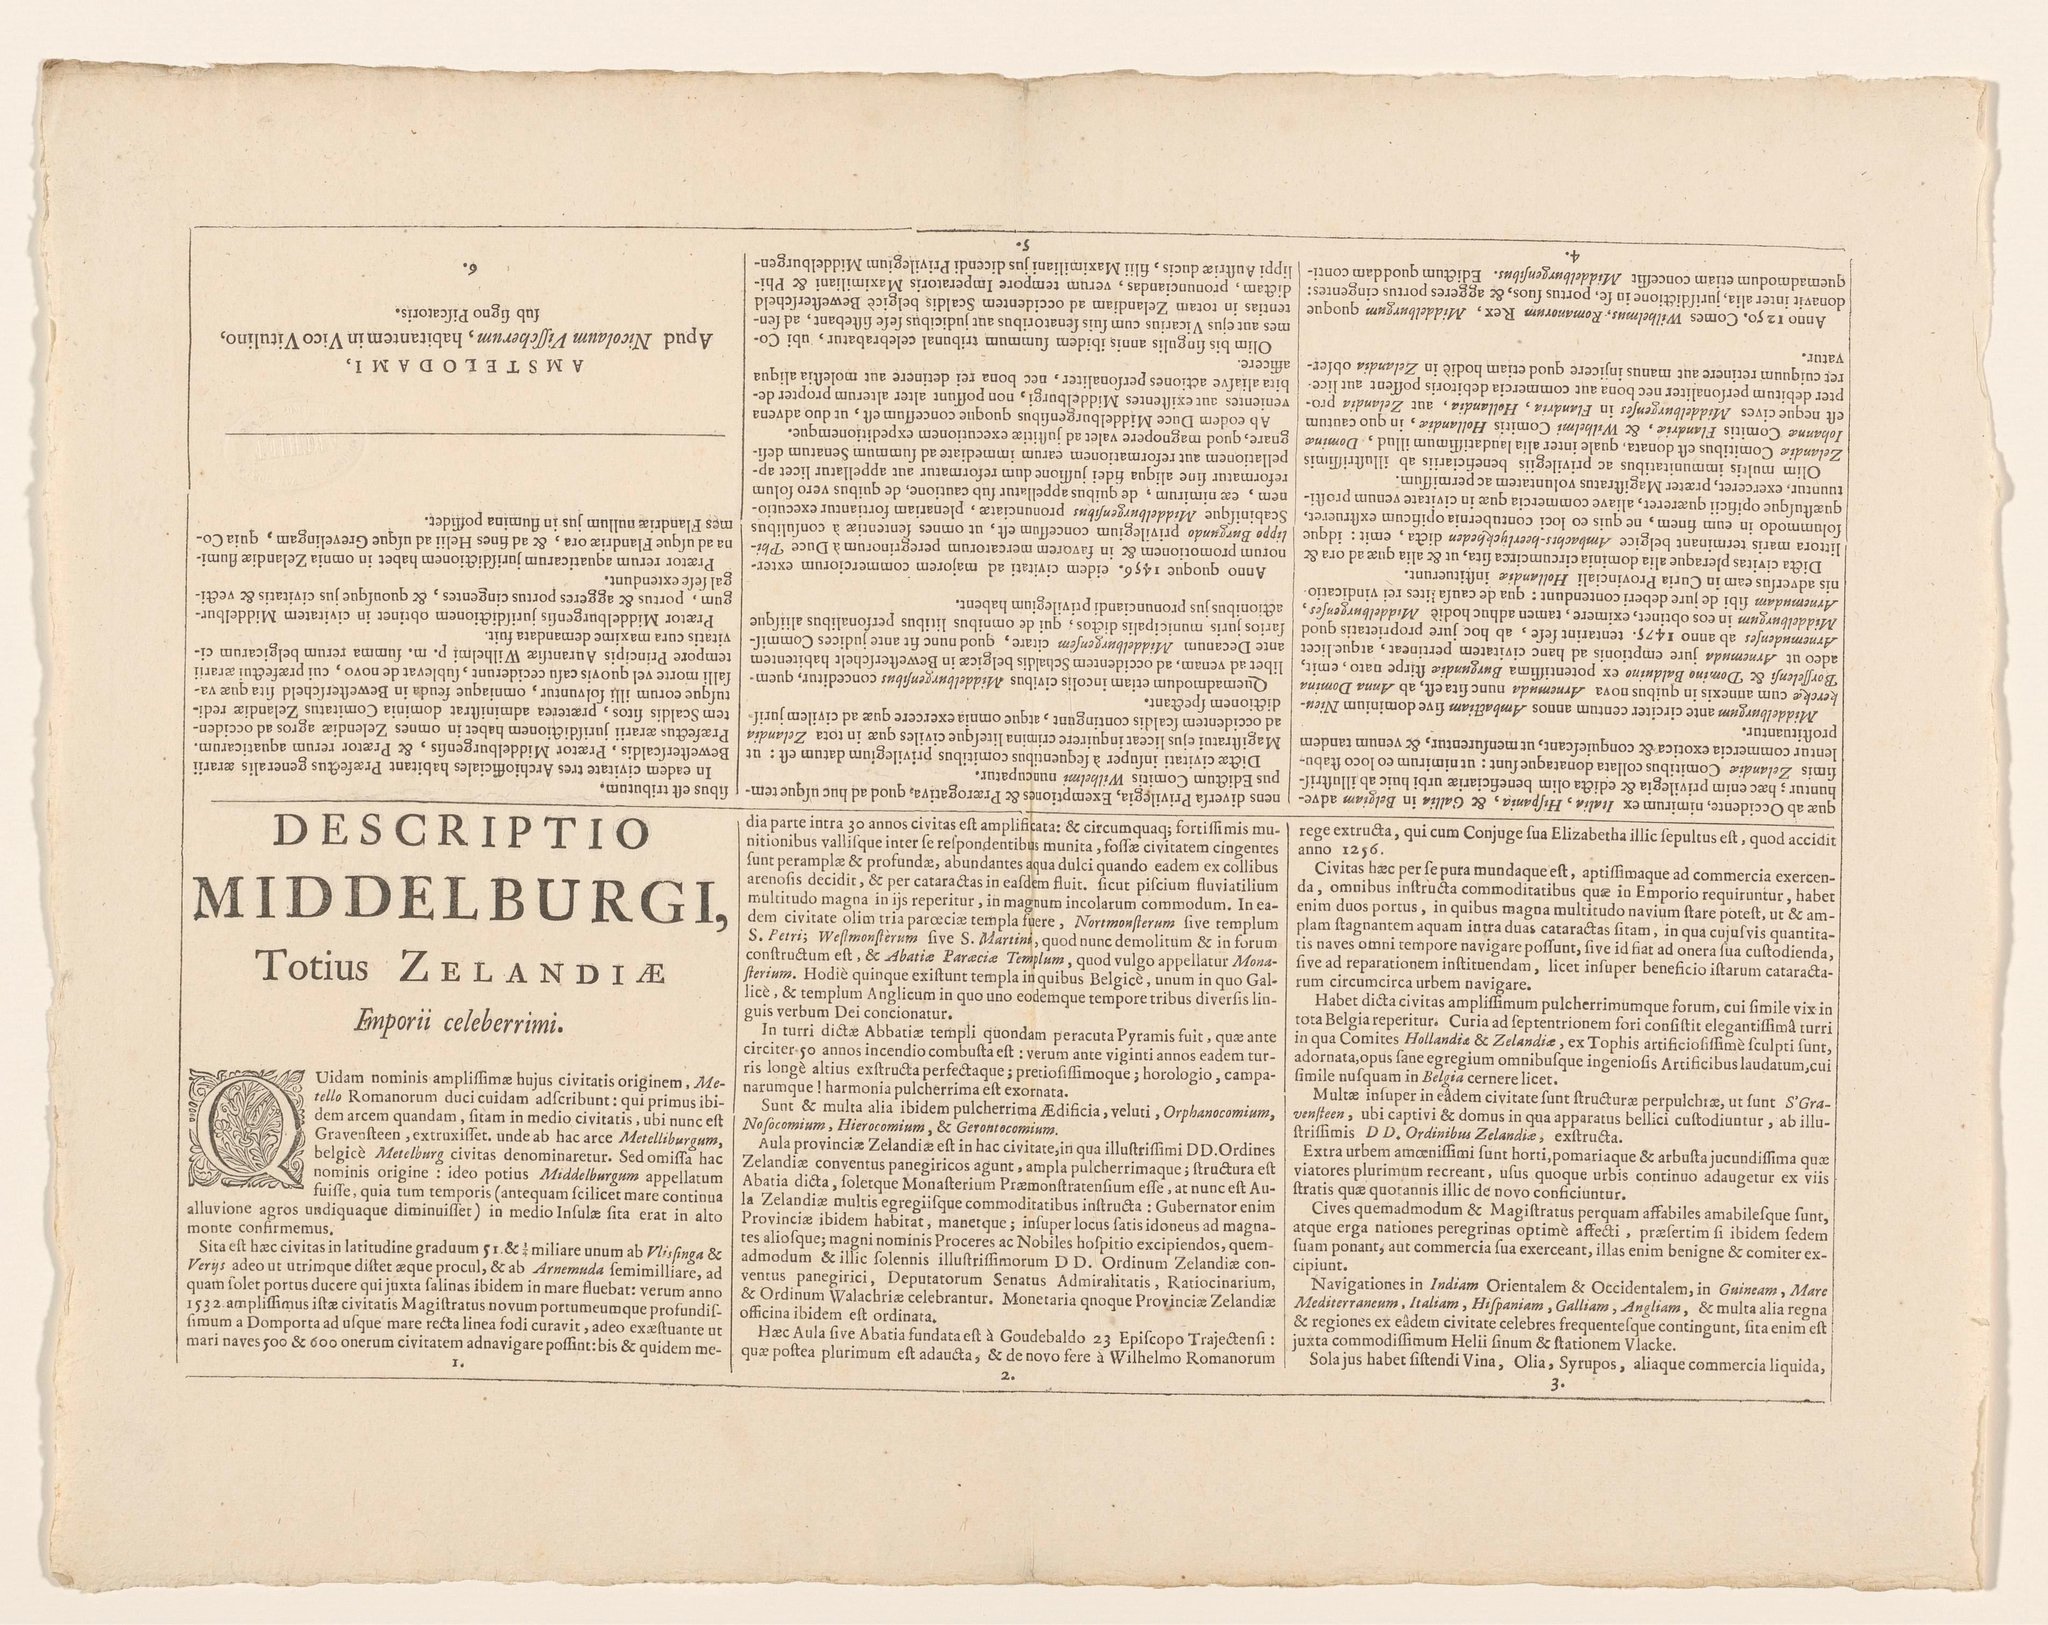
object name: print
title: Titelstrook voor een stadsgezicht van Middelburg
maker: nicolaes visscher (i)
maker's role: print maker, publisher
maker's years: 1618-1679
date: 1652-1679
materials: paper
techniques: woodcut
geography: amsterdam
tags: middelburg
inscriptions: check stamp: ‘Archief Ministerie van Oorlog Afdeeling Genie’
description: Dit blad diende versneden te worden om langs de bovenkant van het bijhorende stadsgezicht geplakt te worden (zie RP-P-AO-15-119).